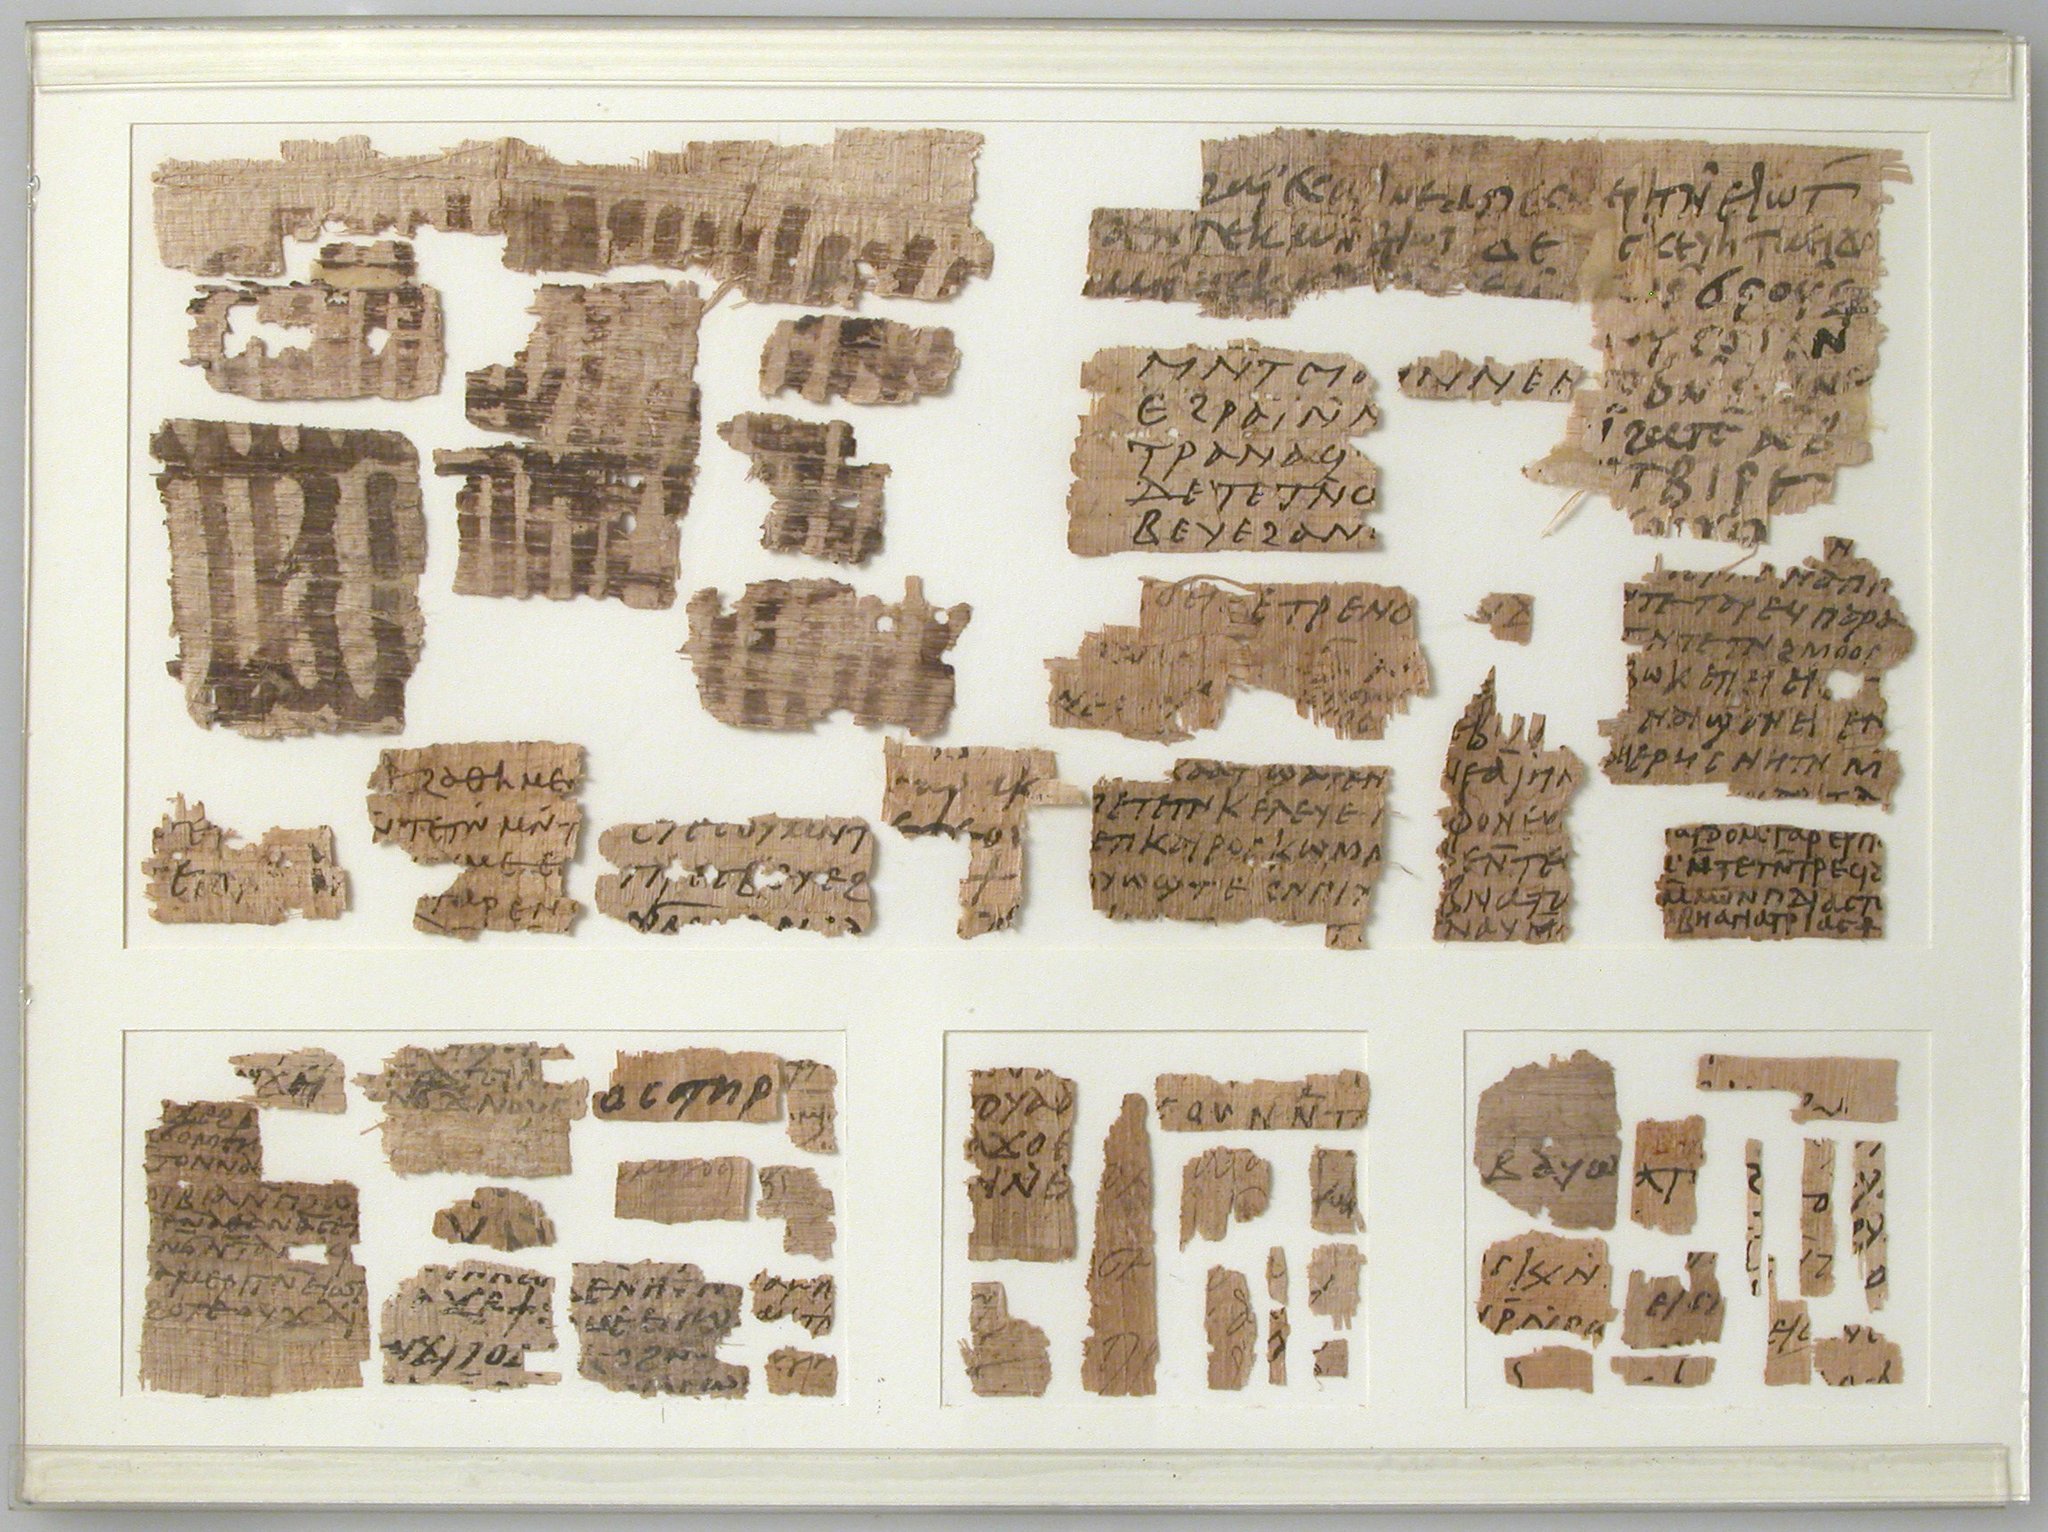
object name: fragment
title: Papyri Fragments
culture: coptic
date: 601-700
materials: ink, papyrus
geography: egypt